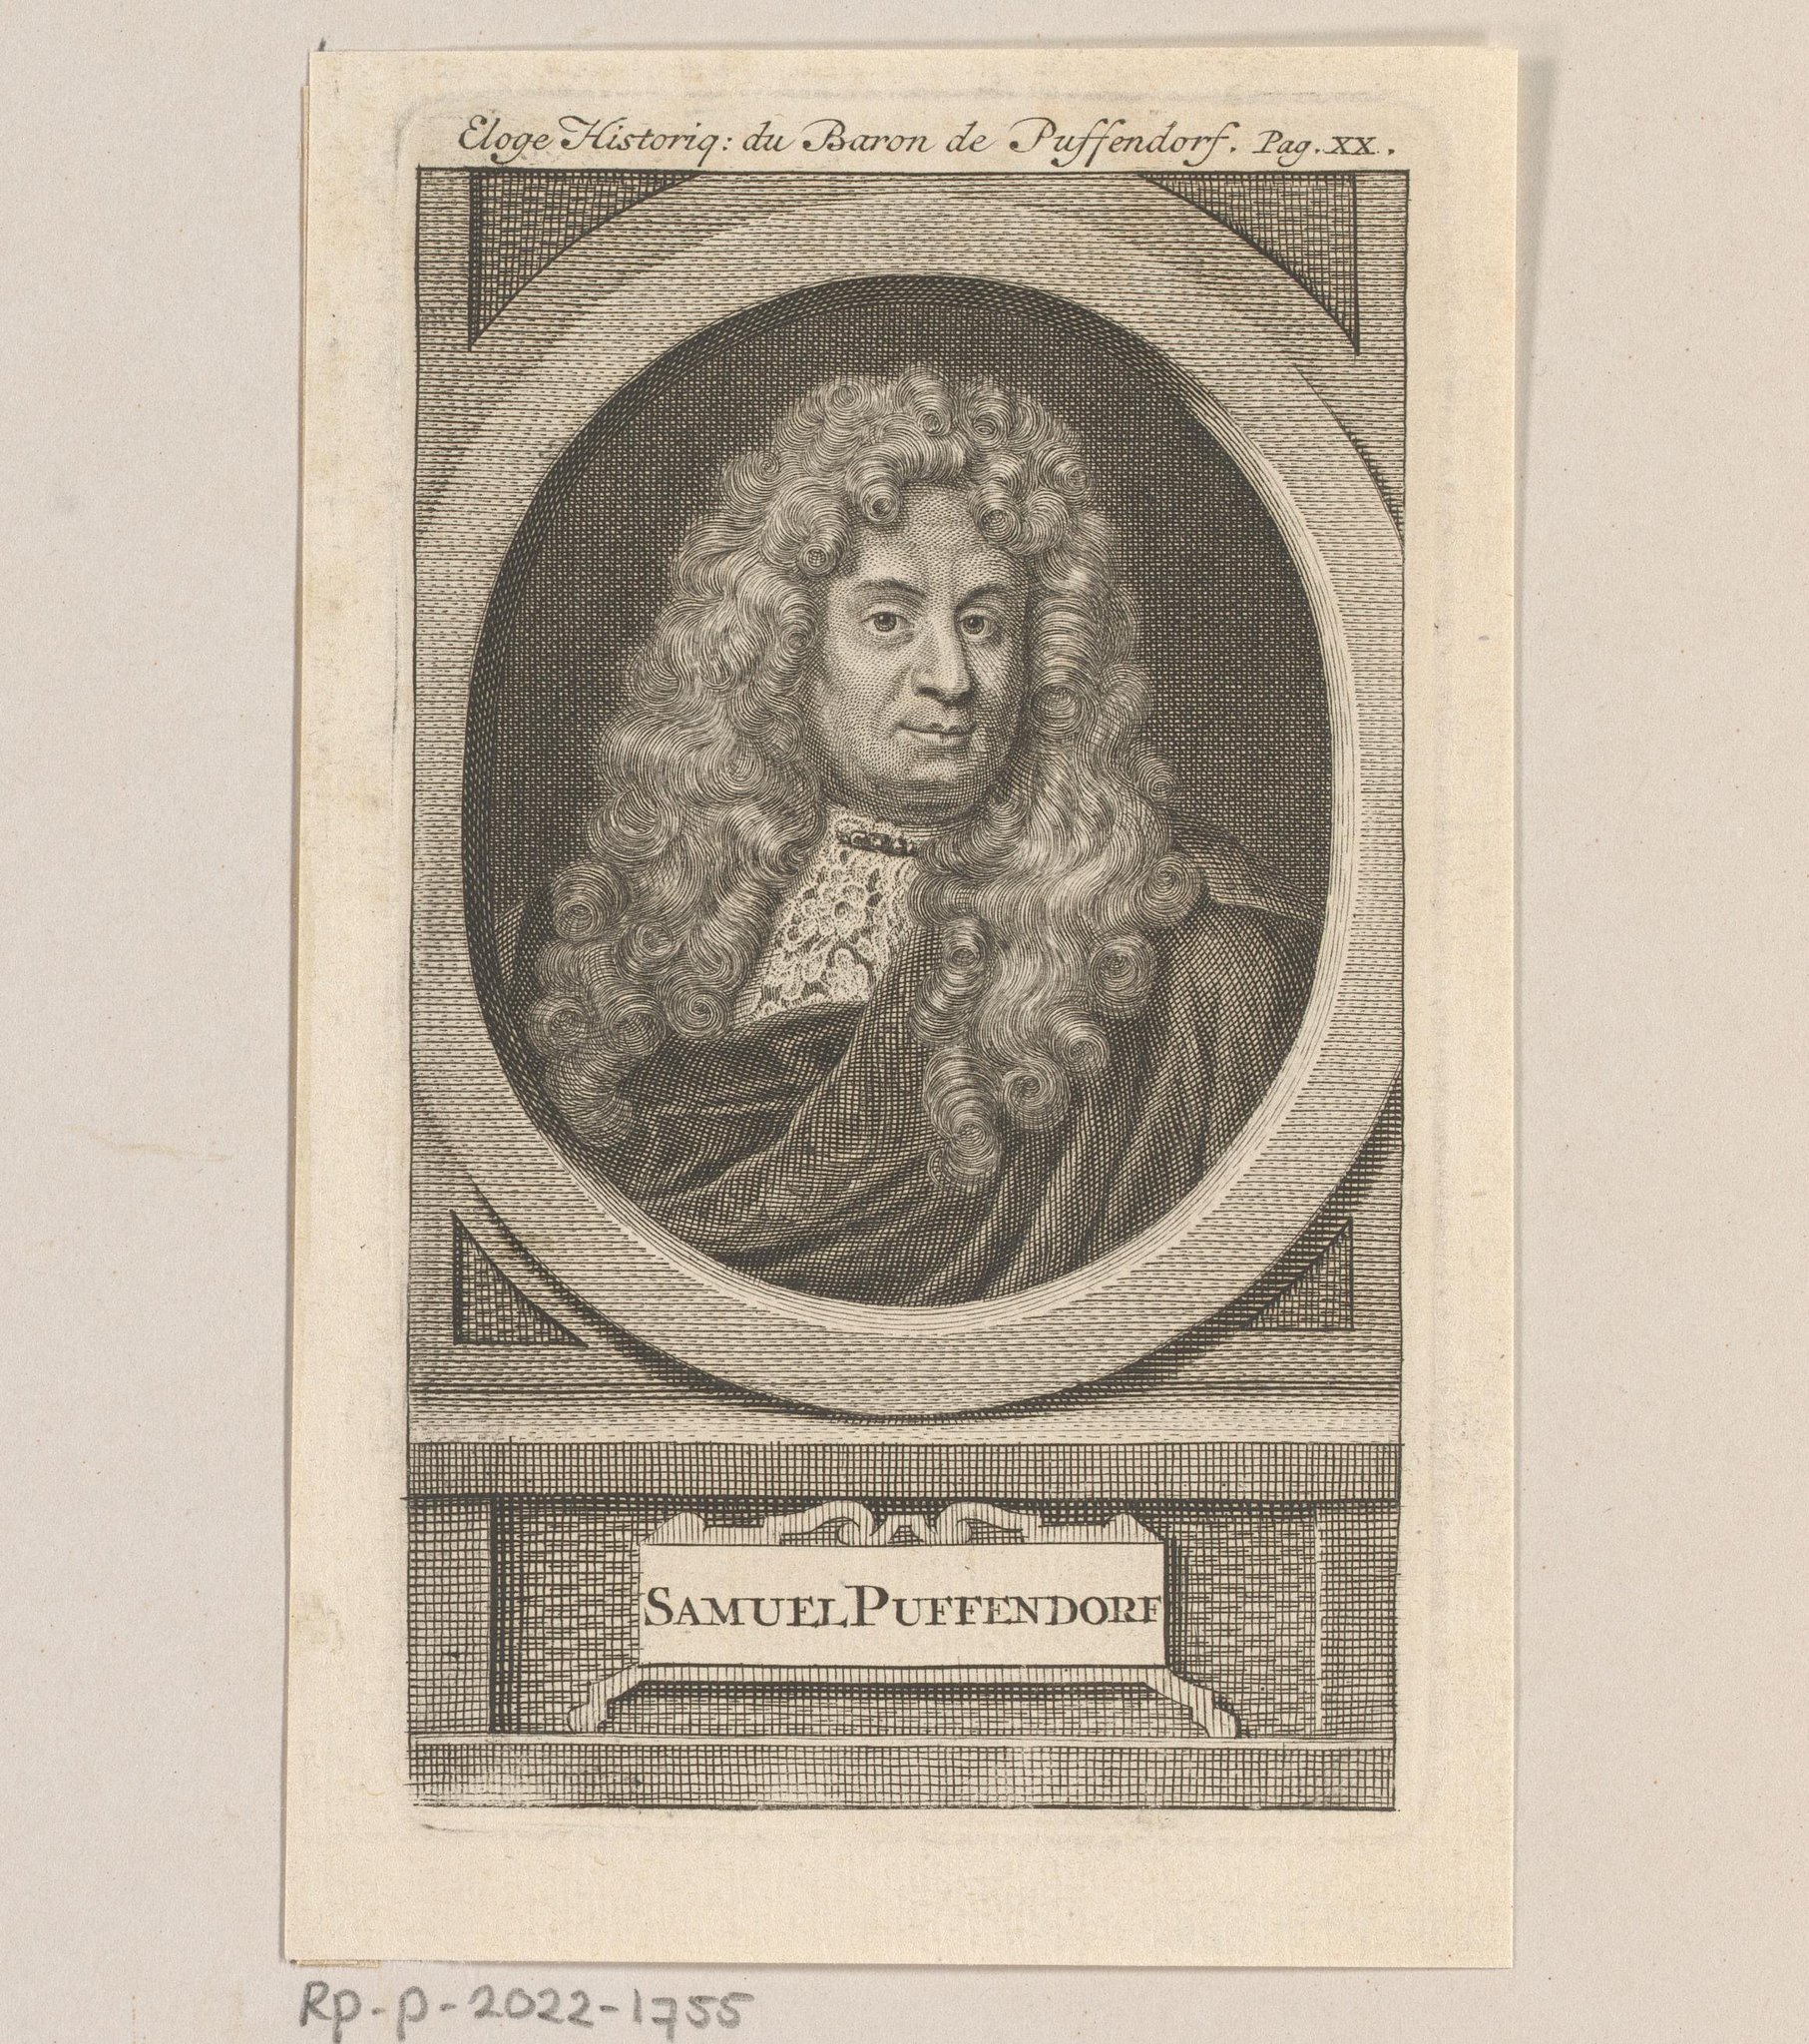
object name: print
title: Portret van Samuel von Pufendorf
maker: Anonymous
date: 1743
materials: paper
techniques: engraving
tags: berlin, history and archaeology (+ portrait of scholar, scientist), scholar, philosopher, historical persons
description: Prent waarschijnlijk uit: Pufendorf, Samuel von en Antoine-Augustin Bruzen de la Martiniere. Introduction à l'histoire générale et politique de l'univers. Amsterdam: Zacharie Chatelain, 1743.